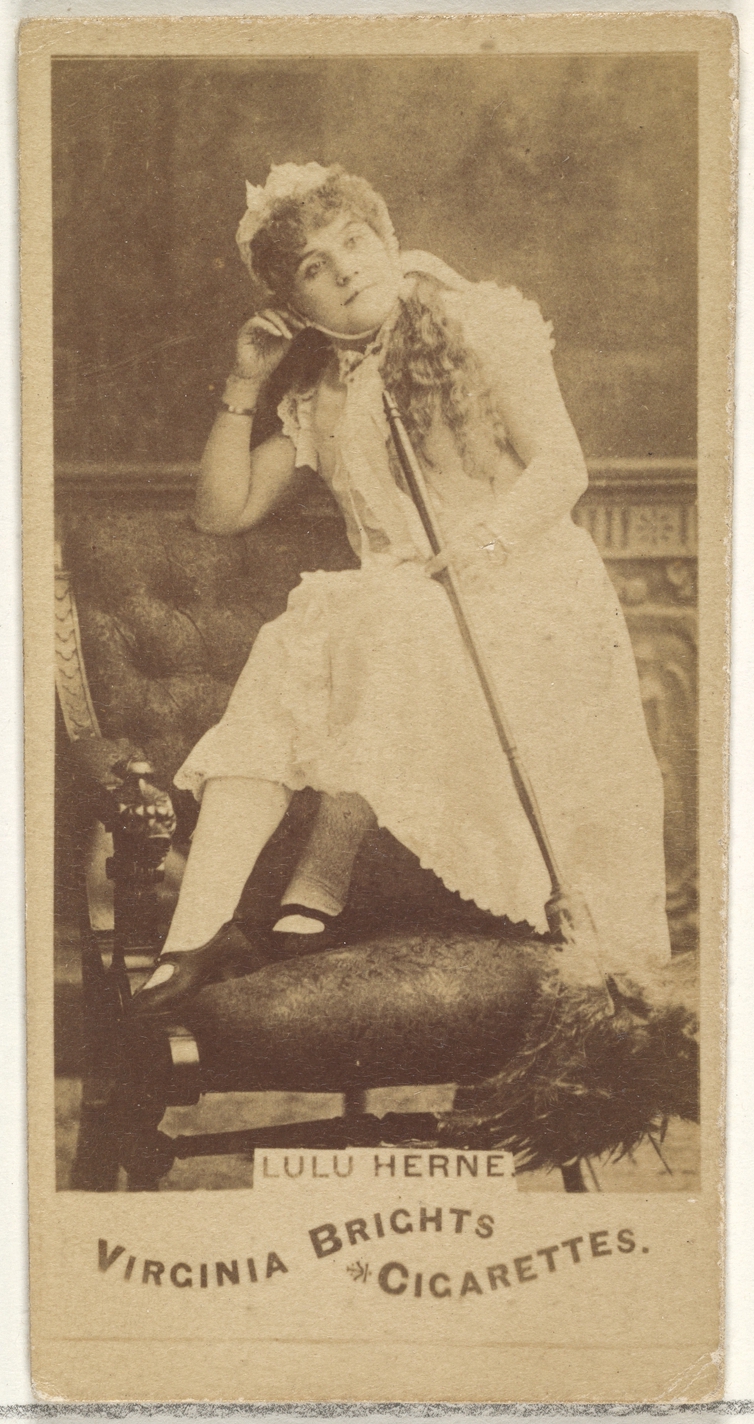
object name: photograph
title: Lulu Herne, from the Actors and Actresses series (N45, Type 1) for Virginia Brights Cigarettes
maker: allen & ginter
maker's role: publisher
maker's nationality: american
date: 1888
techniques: albumen silver print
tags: portraits,women,actresses